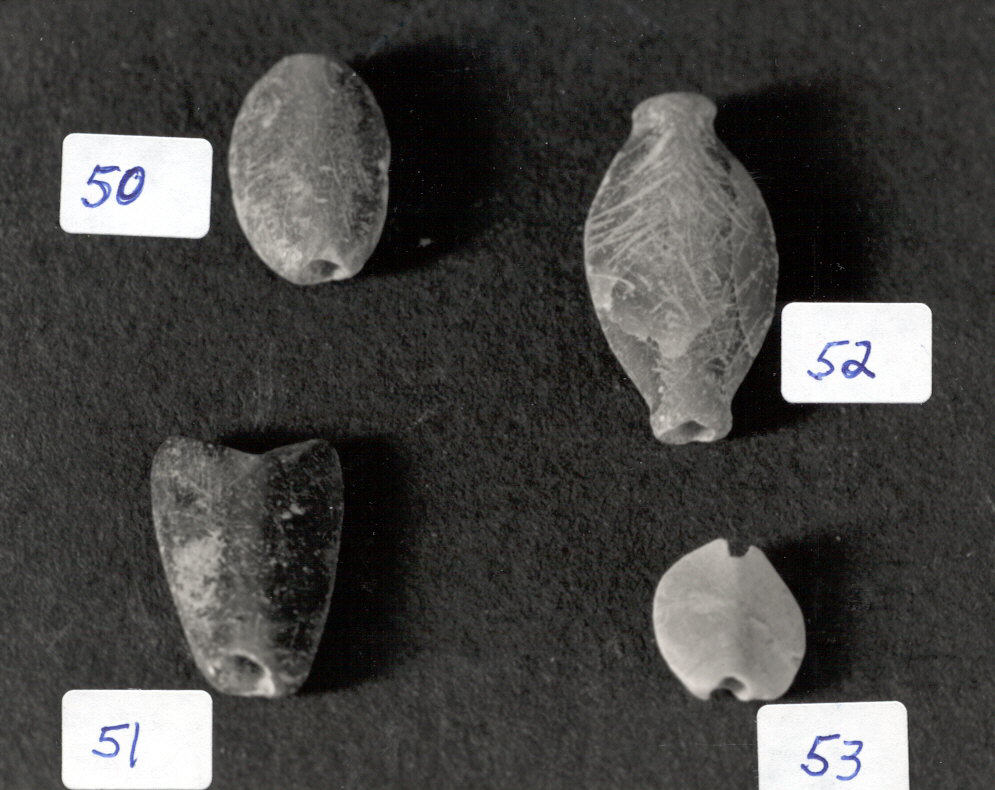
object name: bead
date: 7333-7001 BCE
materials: mineral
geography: syria